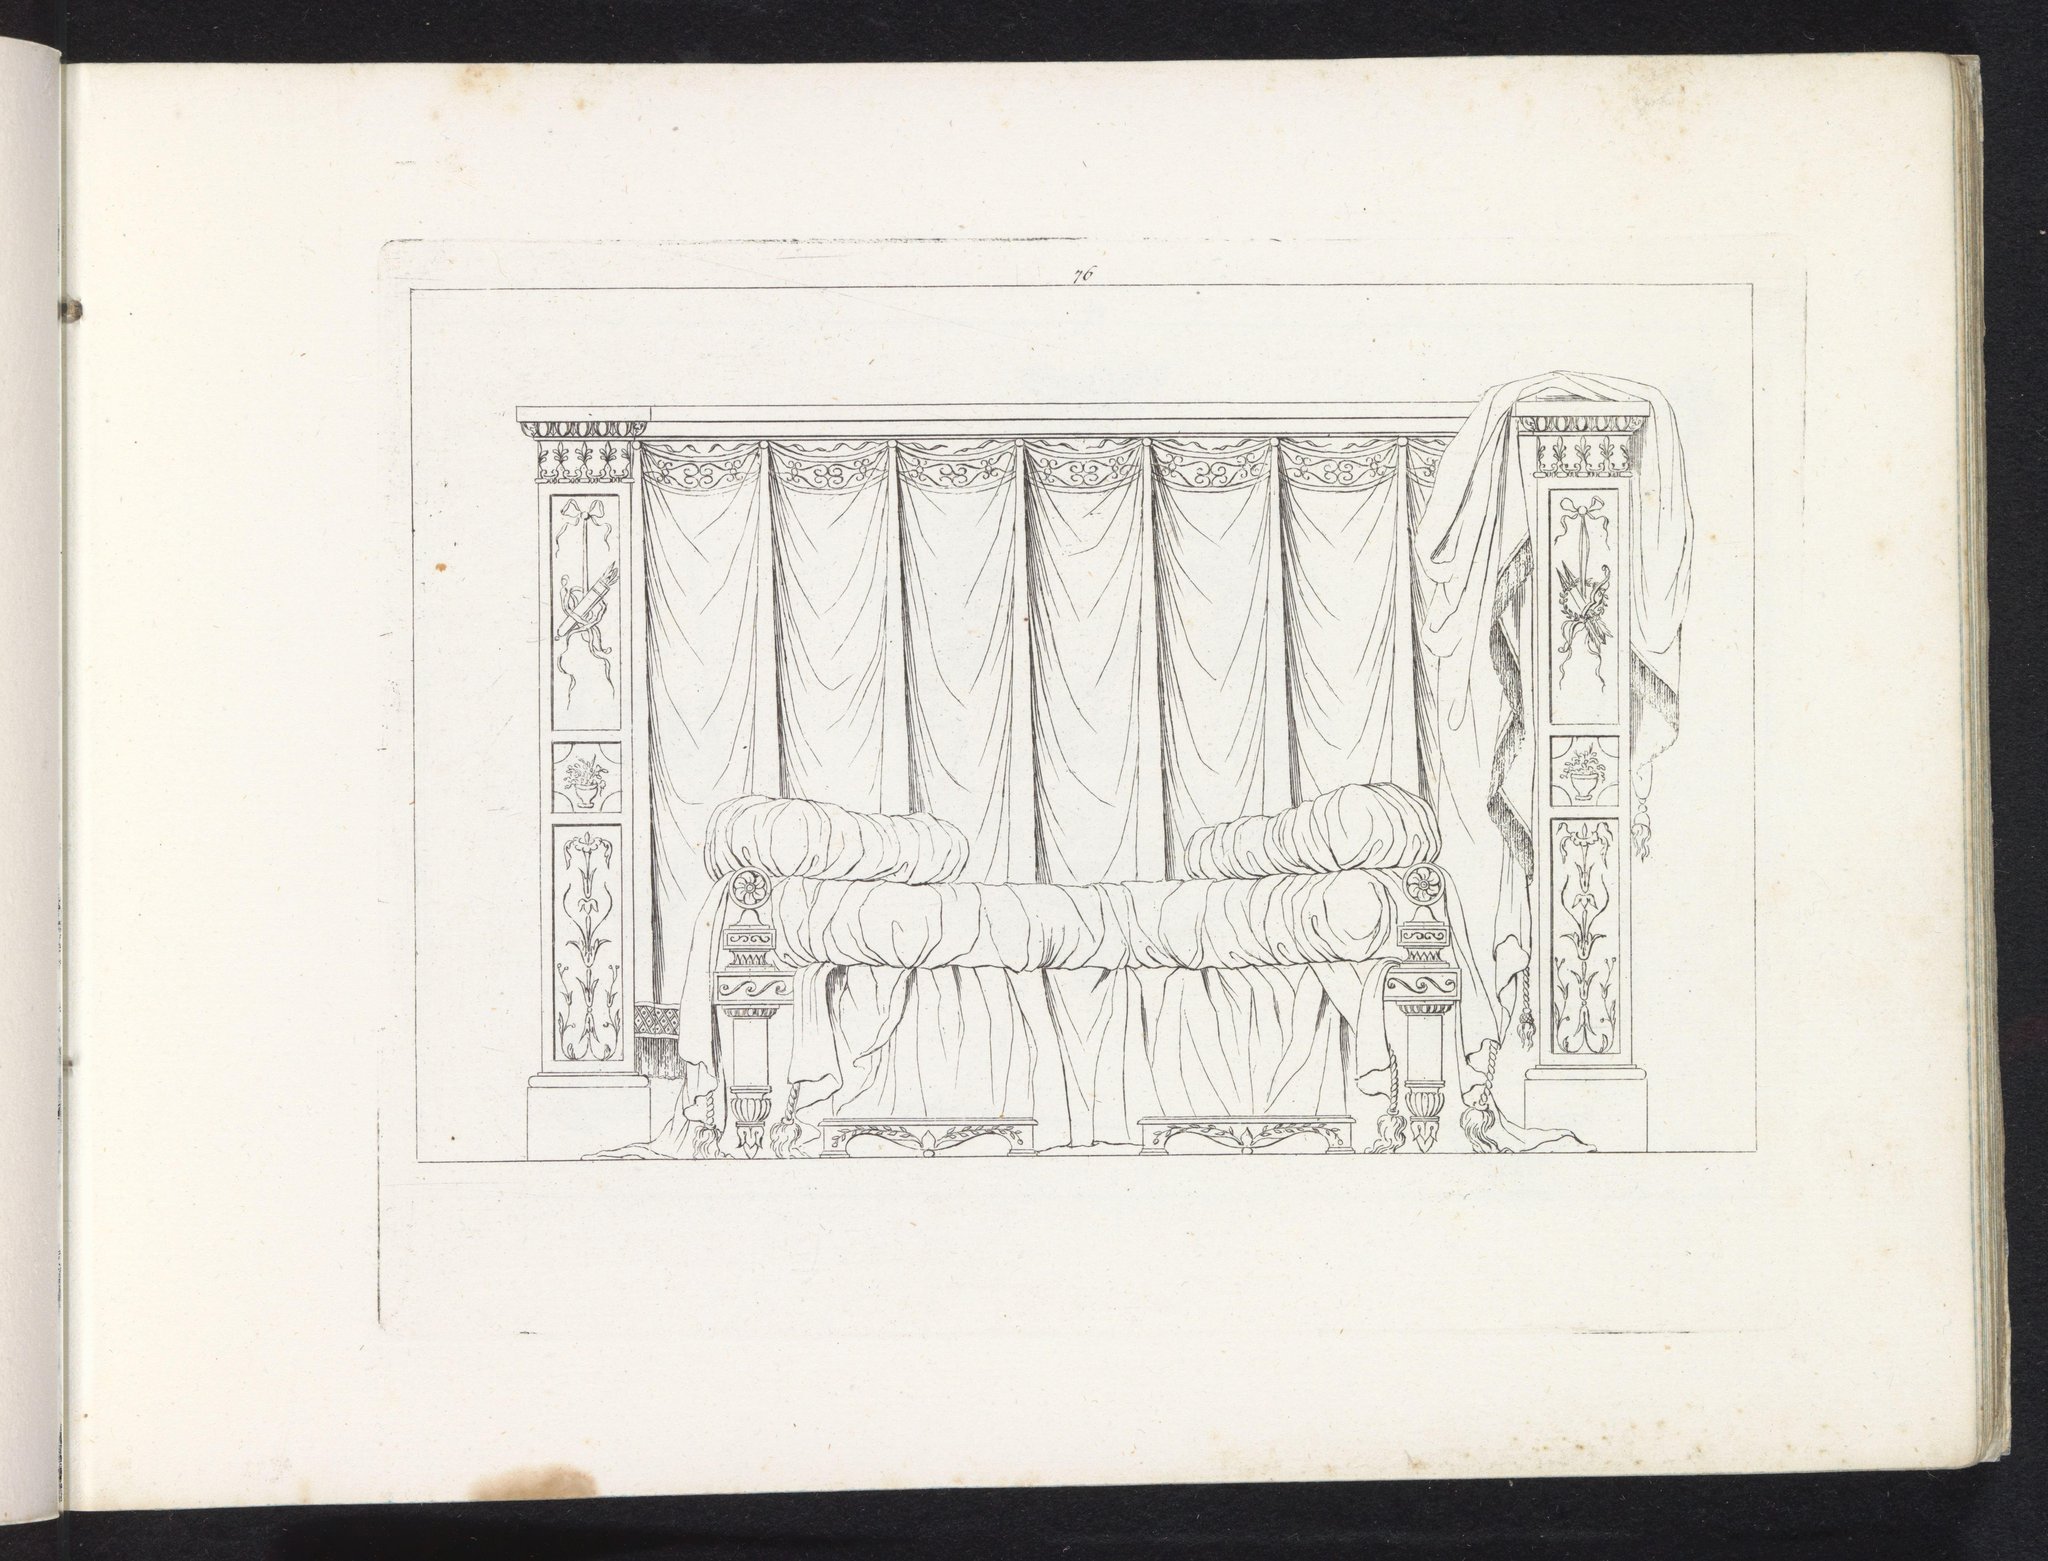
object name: album leaf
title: Ontwerpen voor religieuze en profane voorwerpen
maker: pietro ruga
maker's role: print maker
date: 1817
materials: paper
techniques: etching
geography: italy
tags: ornaments ~ art, bed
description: Prent maakt deel uit van een reeks van 100 prenten (+ titelprent) met ontwerpen voor religieuze en profane voorwerpen.